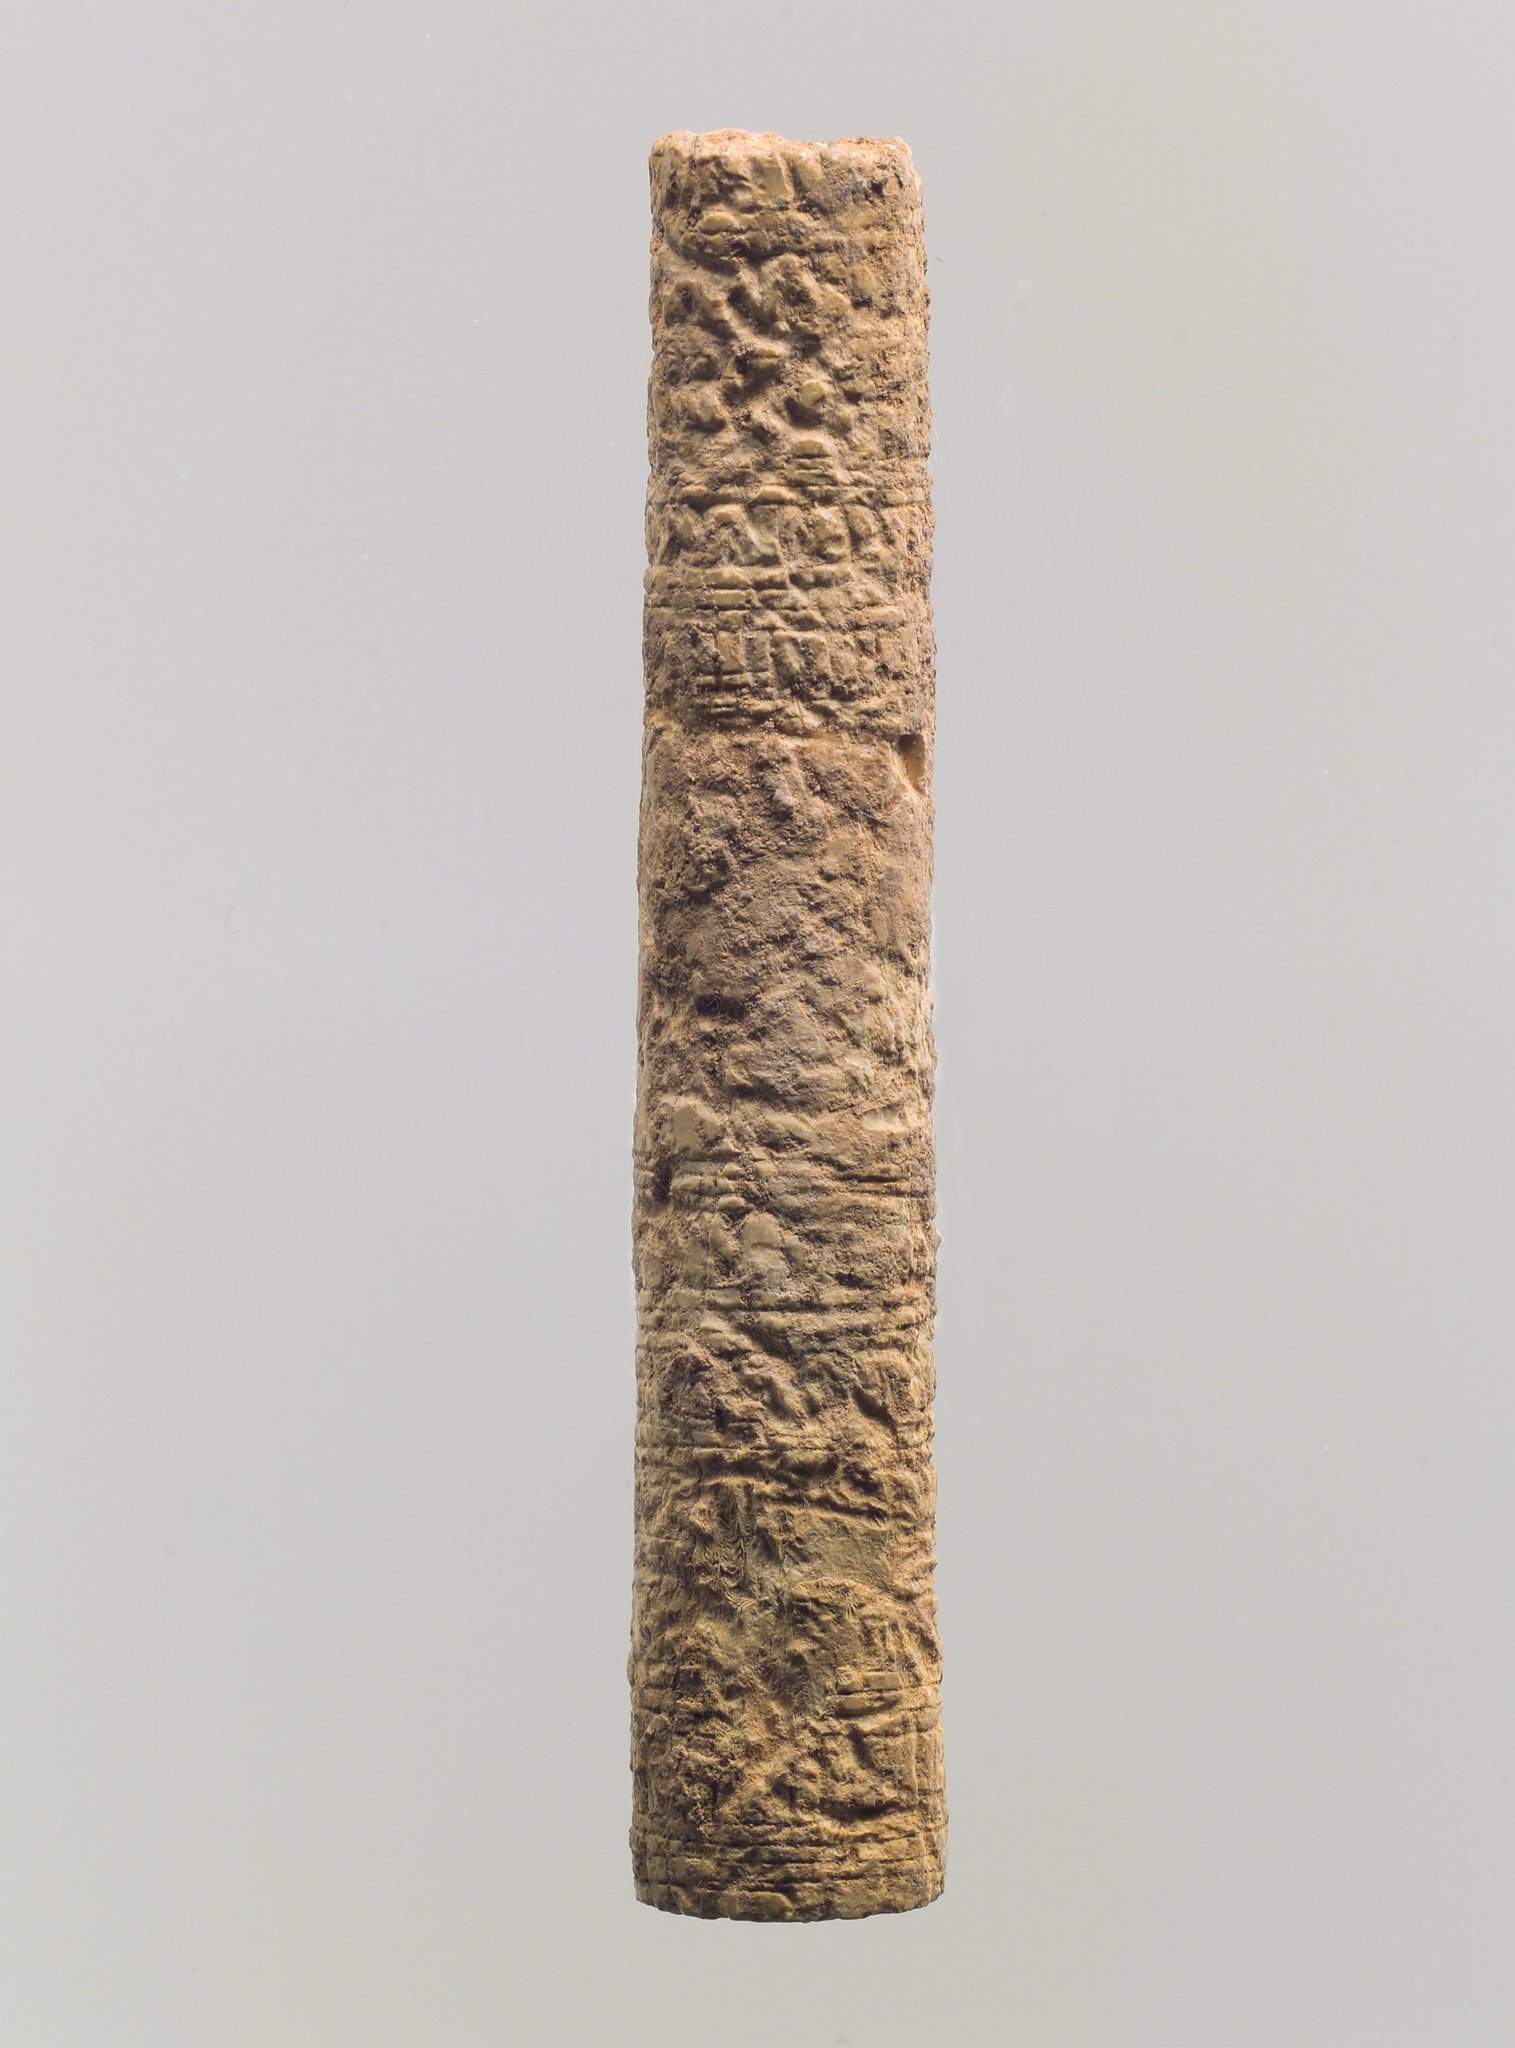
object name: handle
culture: iranian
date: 800-601 BCE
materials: ivory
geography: iran, luristan